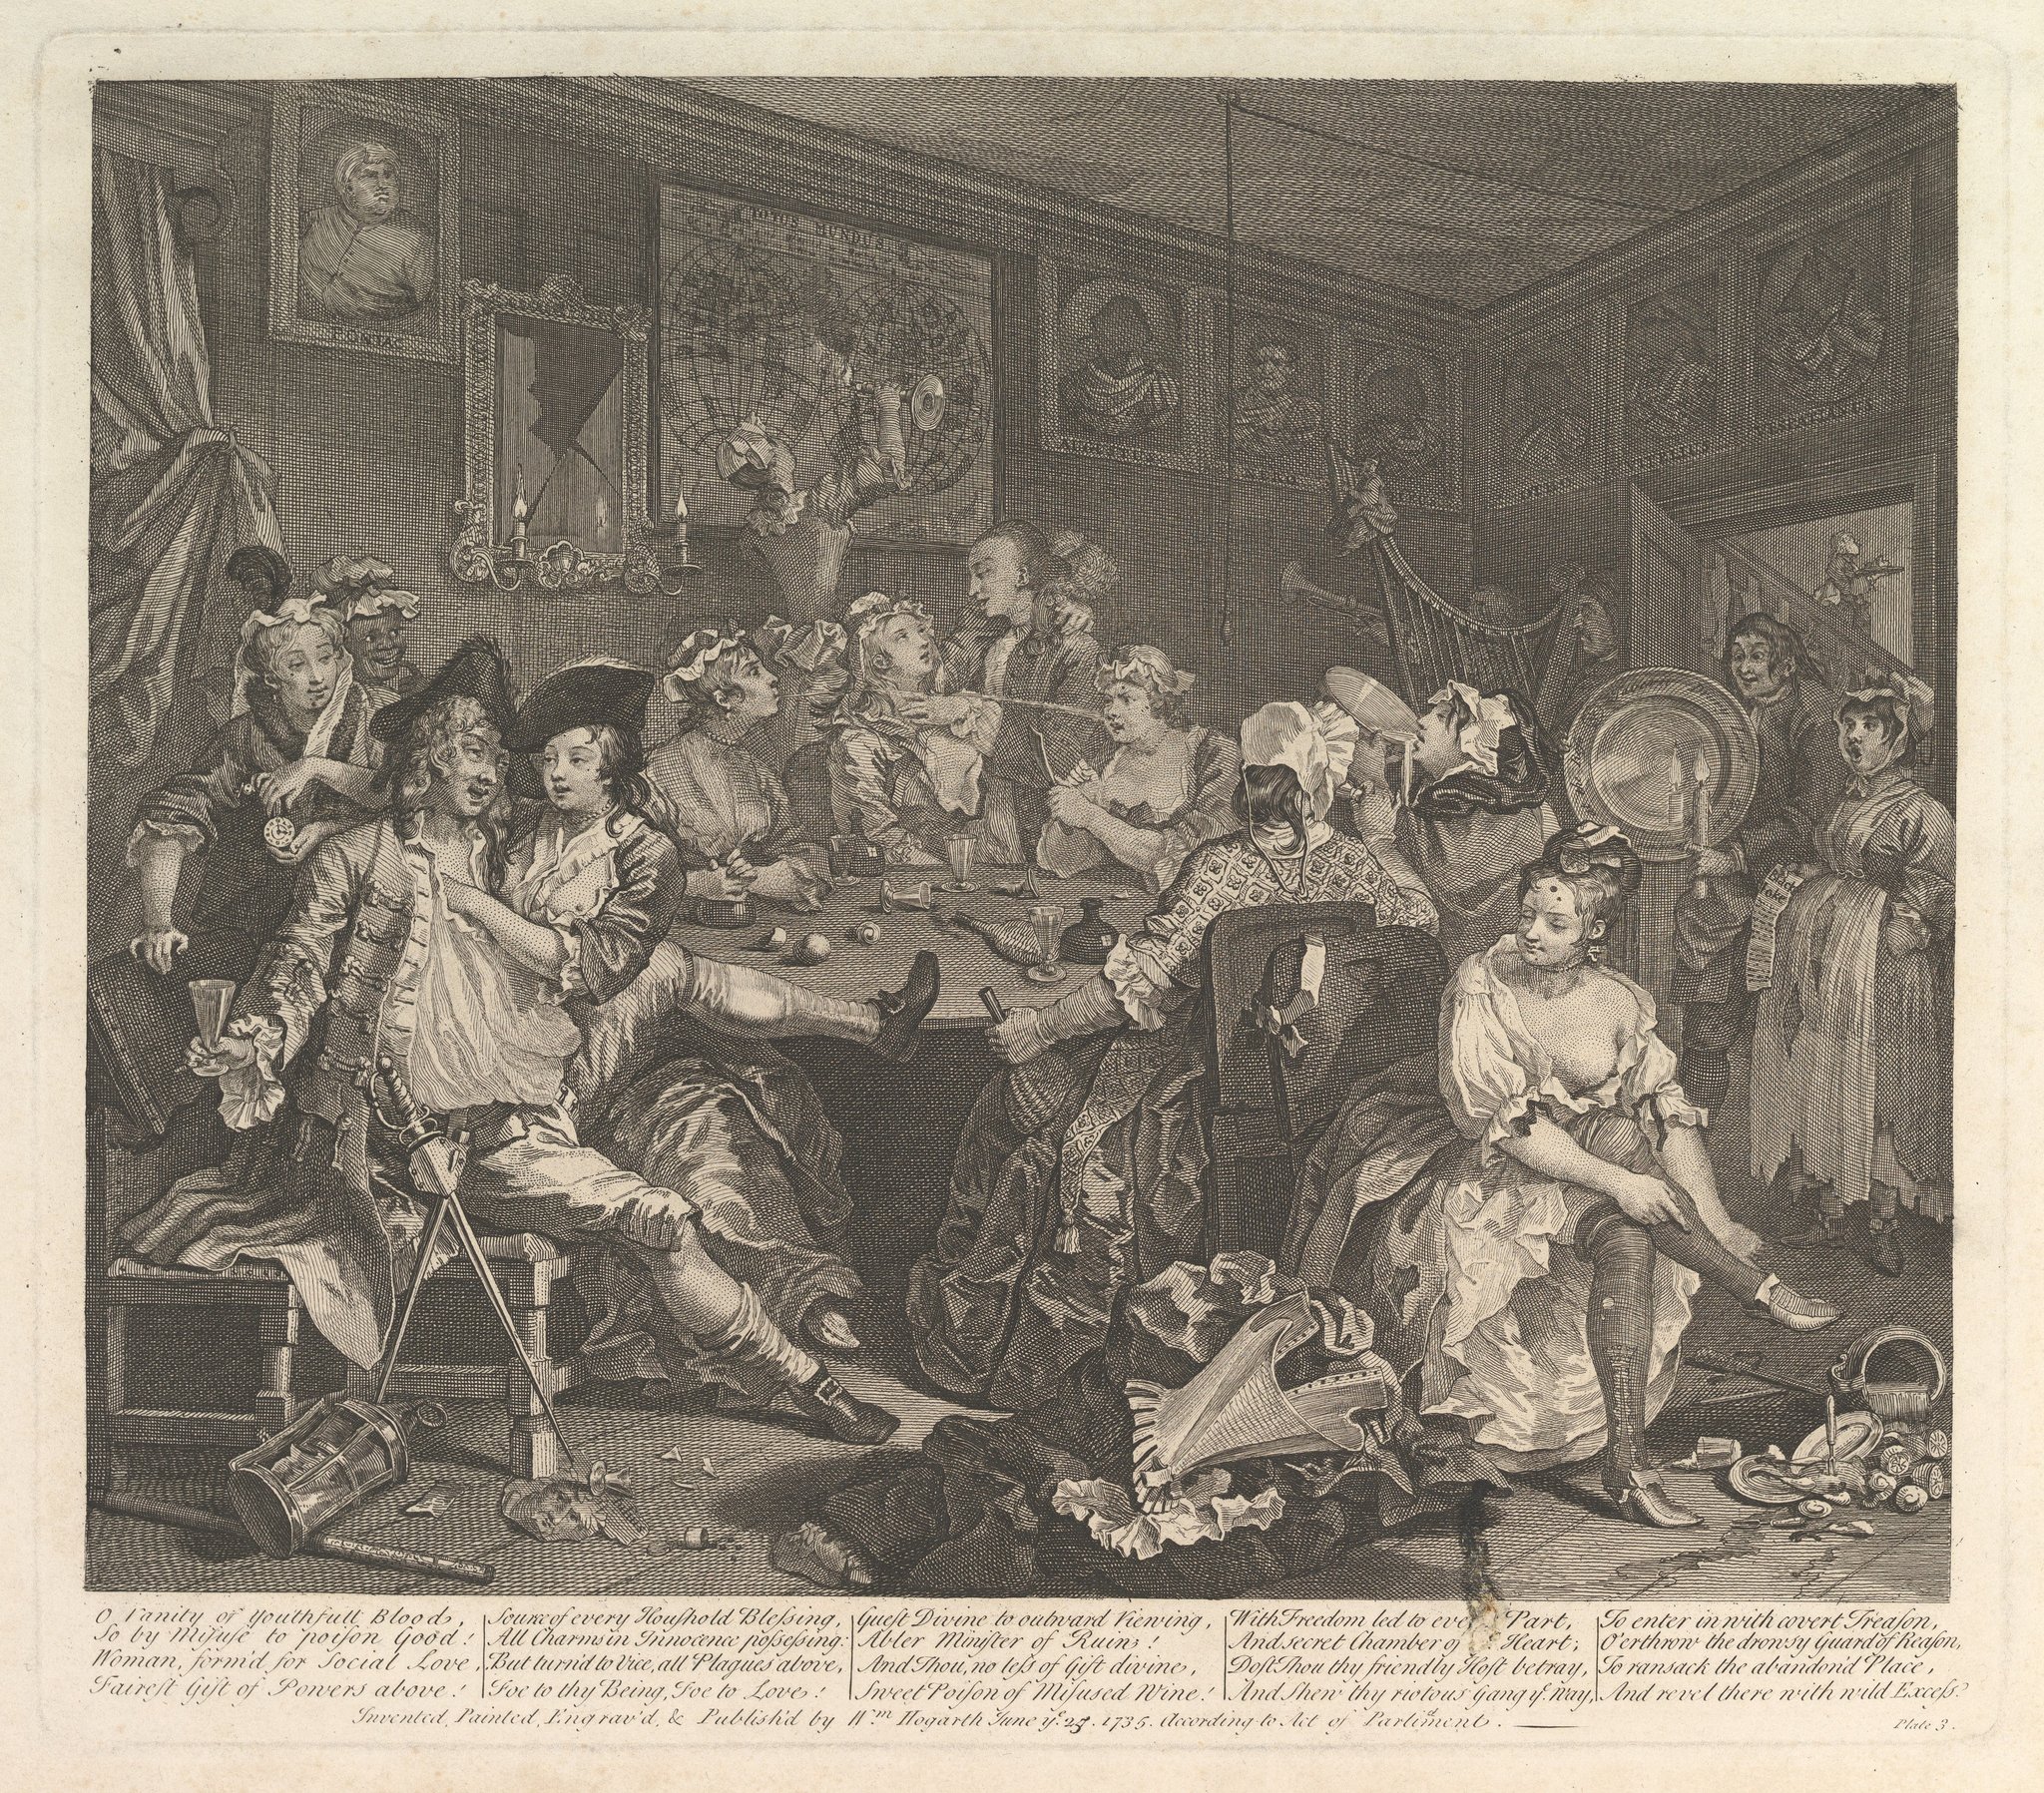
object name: print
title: A Rake's Progress, Plate 3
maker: william hogarth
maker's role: artist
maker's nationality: british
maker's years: 1697-1764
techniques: engraving, etching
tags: interiors,men,women,drinking,prostitutes